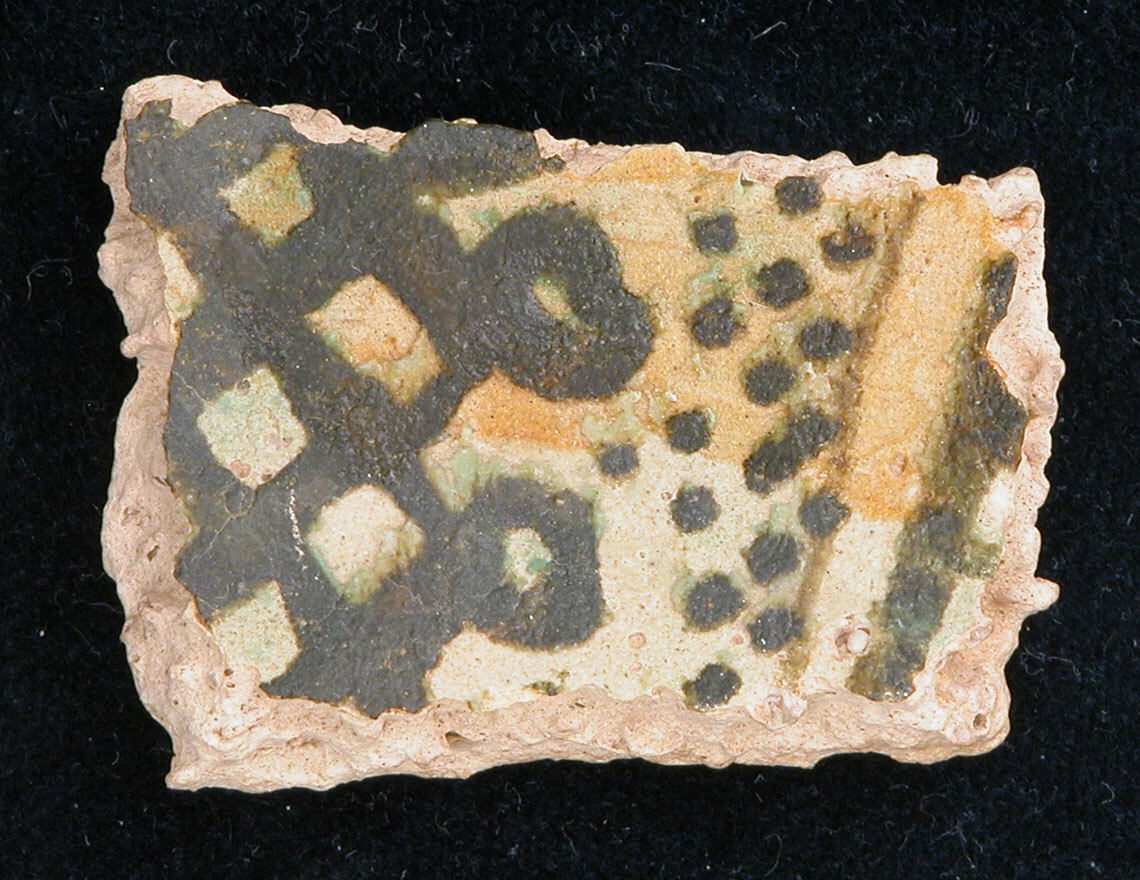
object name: fragment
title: Ceramic Fragment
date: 1101-1300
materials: earthenware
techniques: glazing, painting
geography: saudi arabia